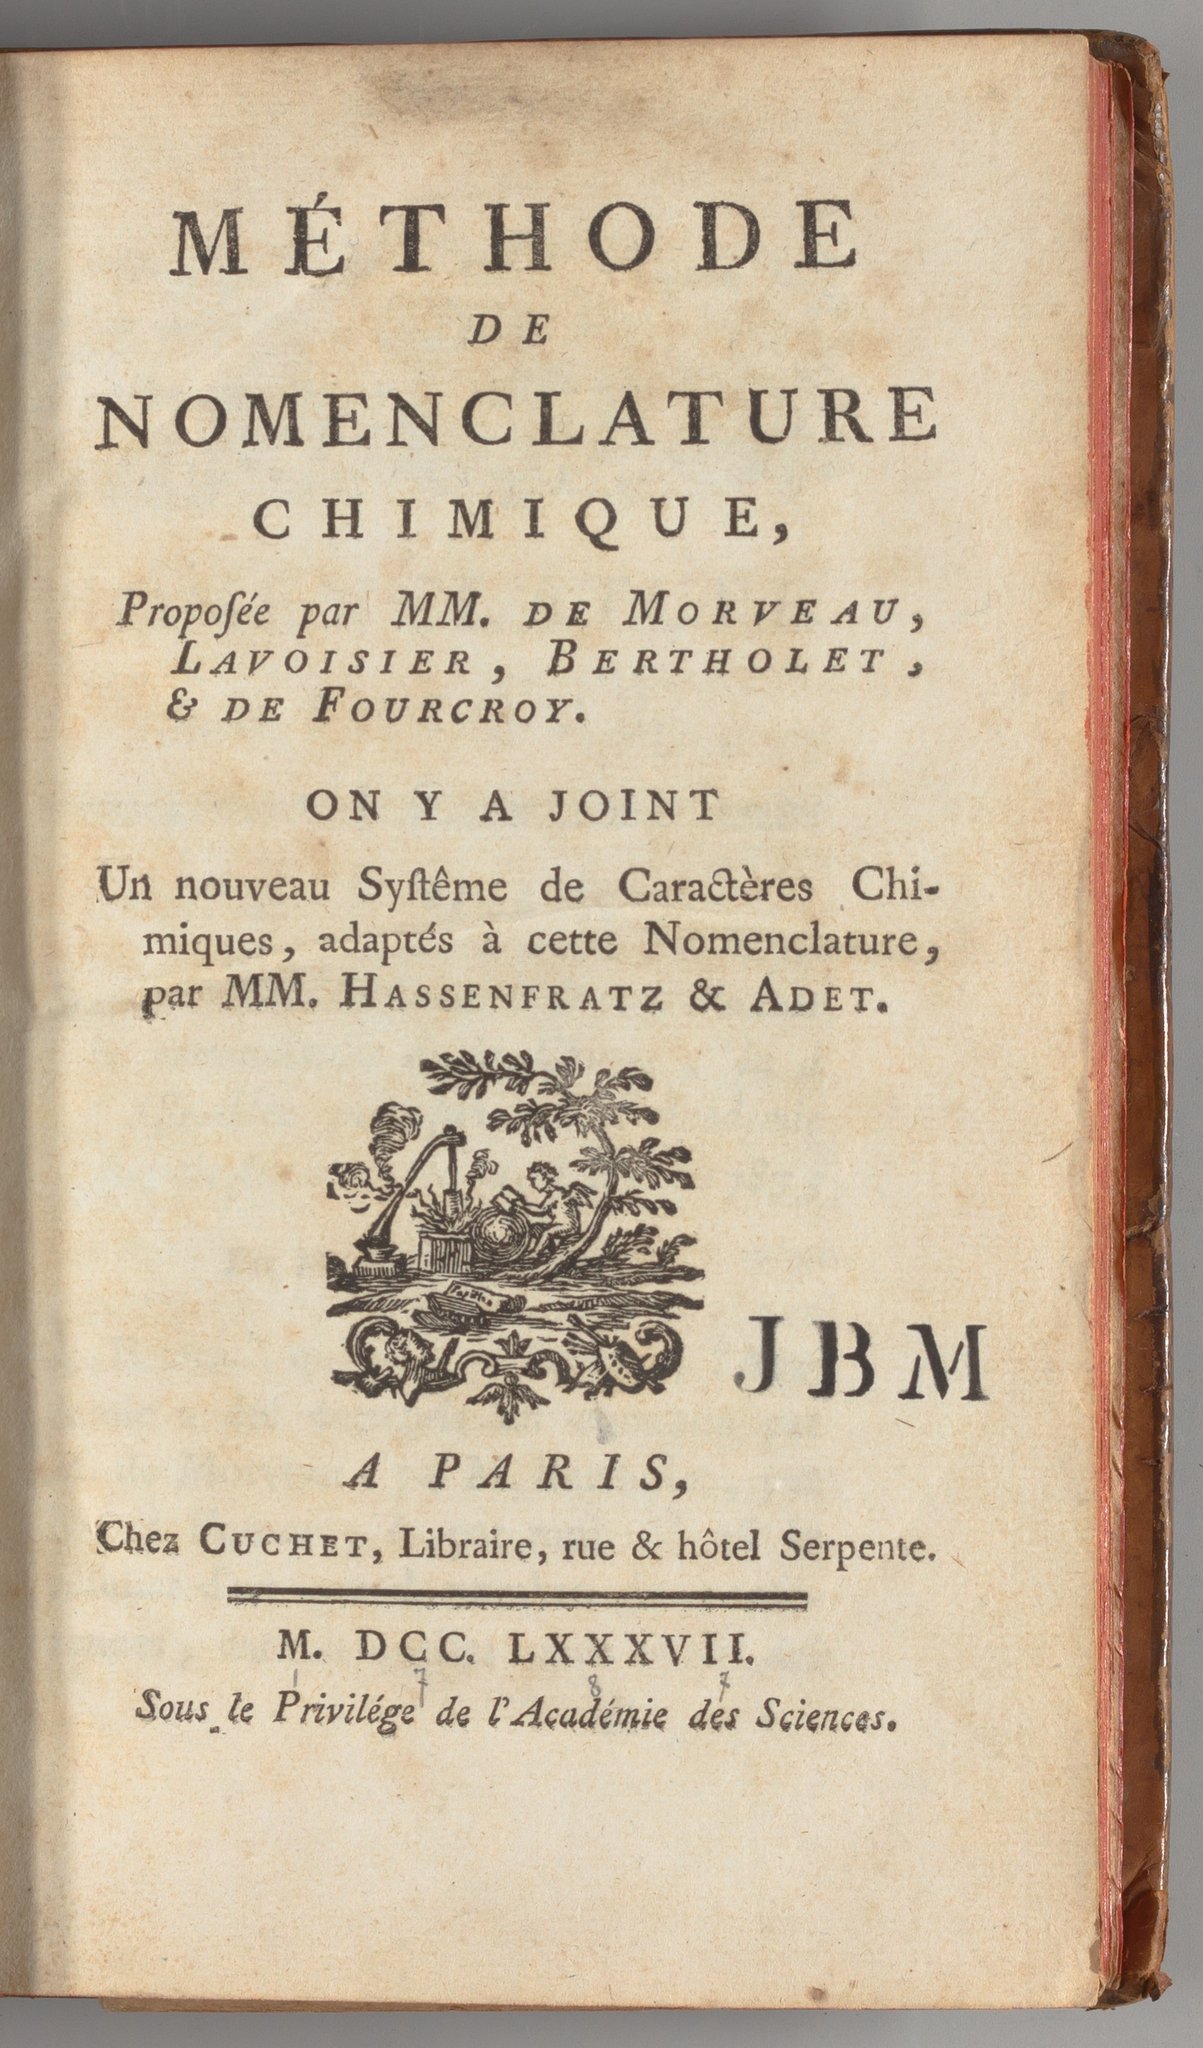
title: Méthode de nomenclature chimique ; on y a joint un nouveau systême de caractères chimiques, adaptés à cette nomenclature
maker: louis-bernard guyton de morveau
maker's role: author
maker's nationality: french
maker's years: 1737-1816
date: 1787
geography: france